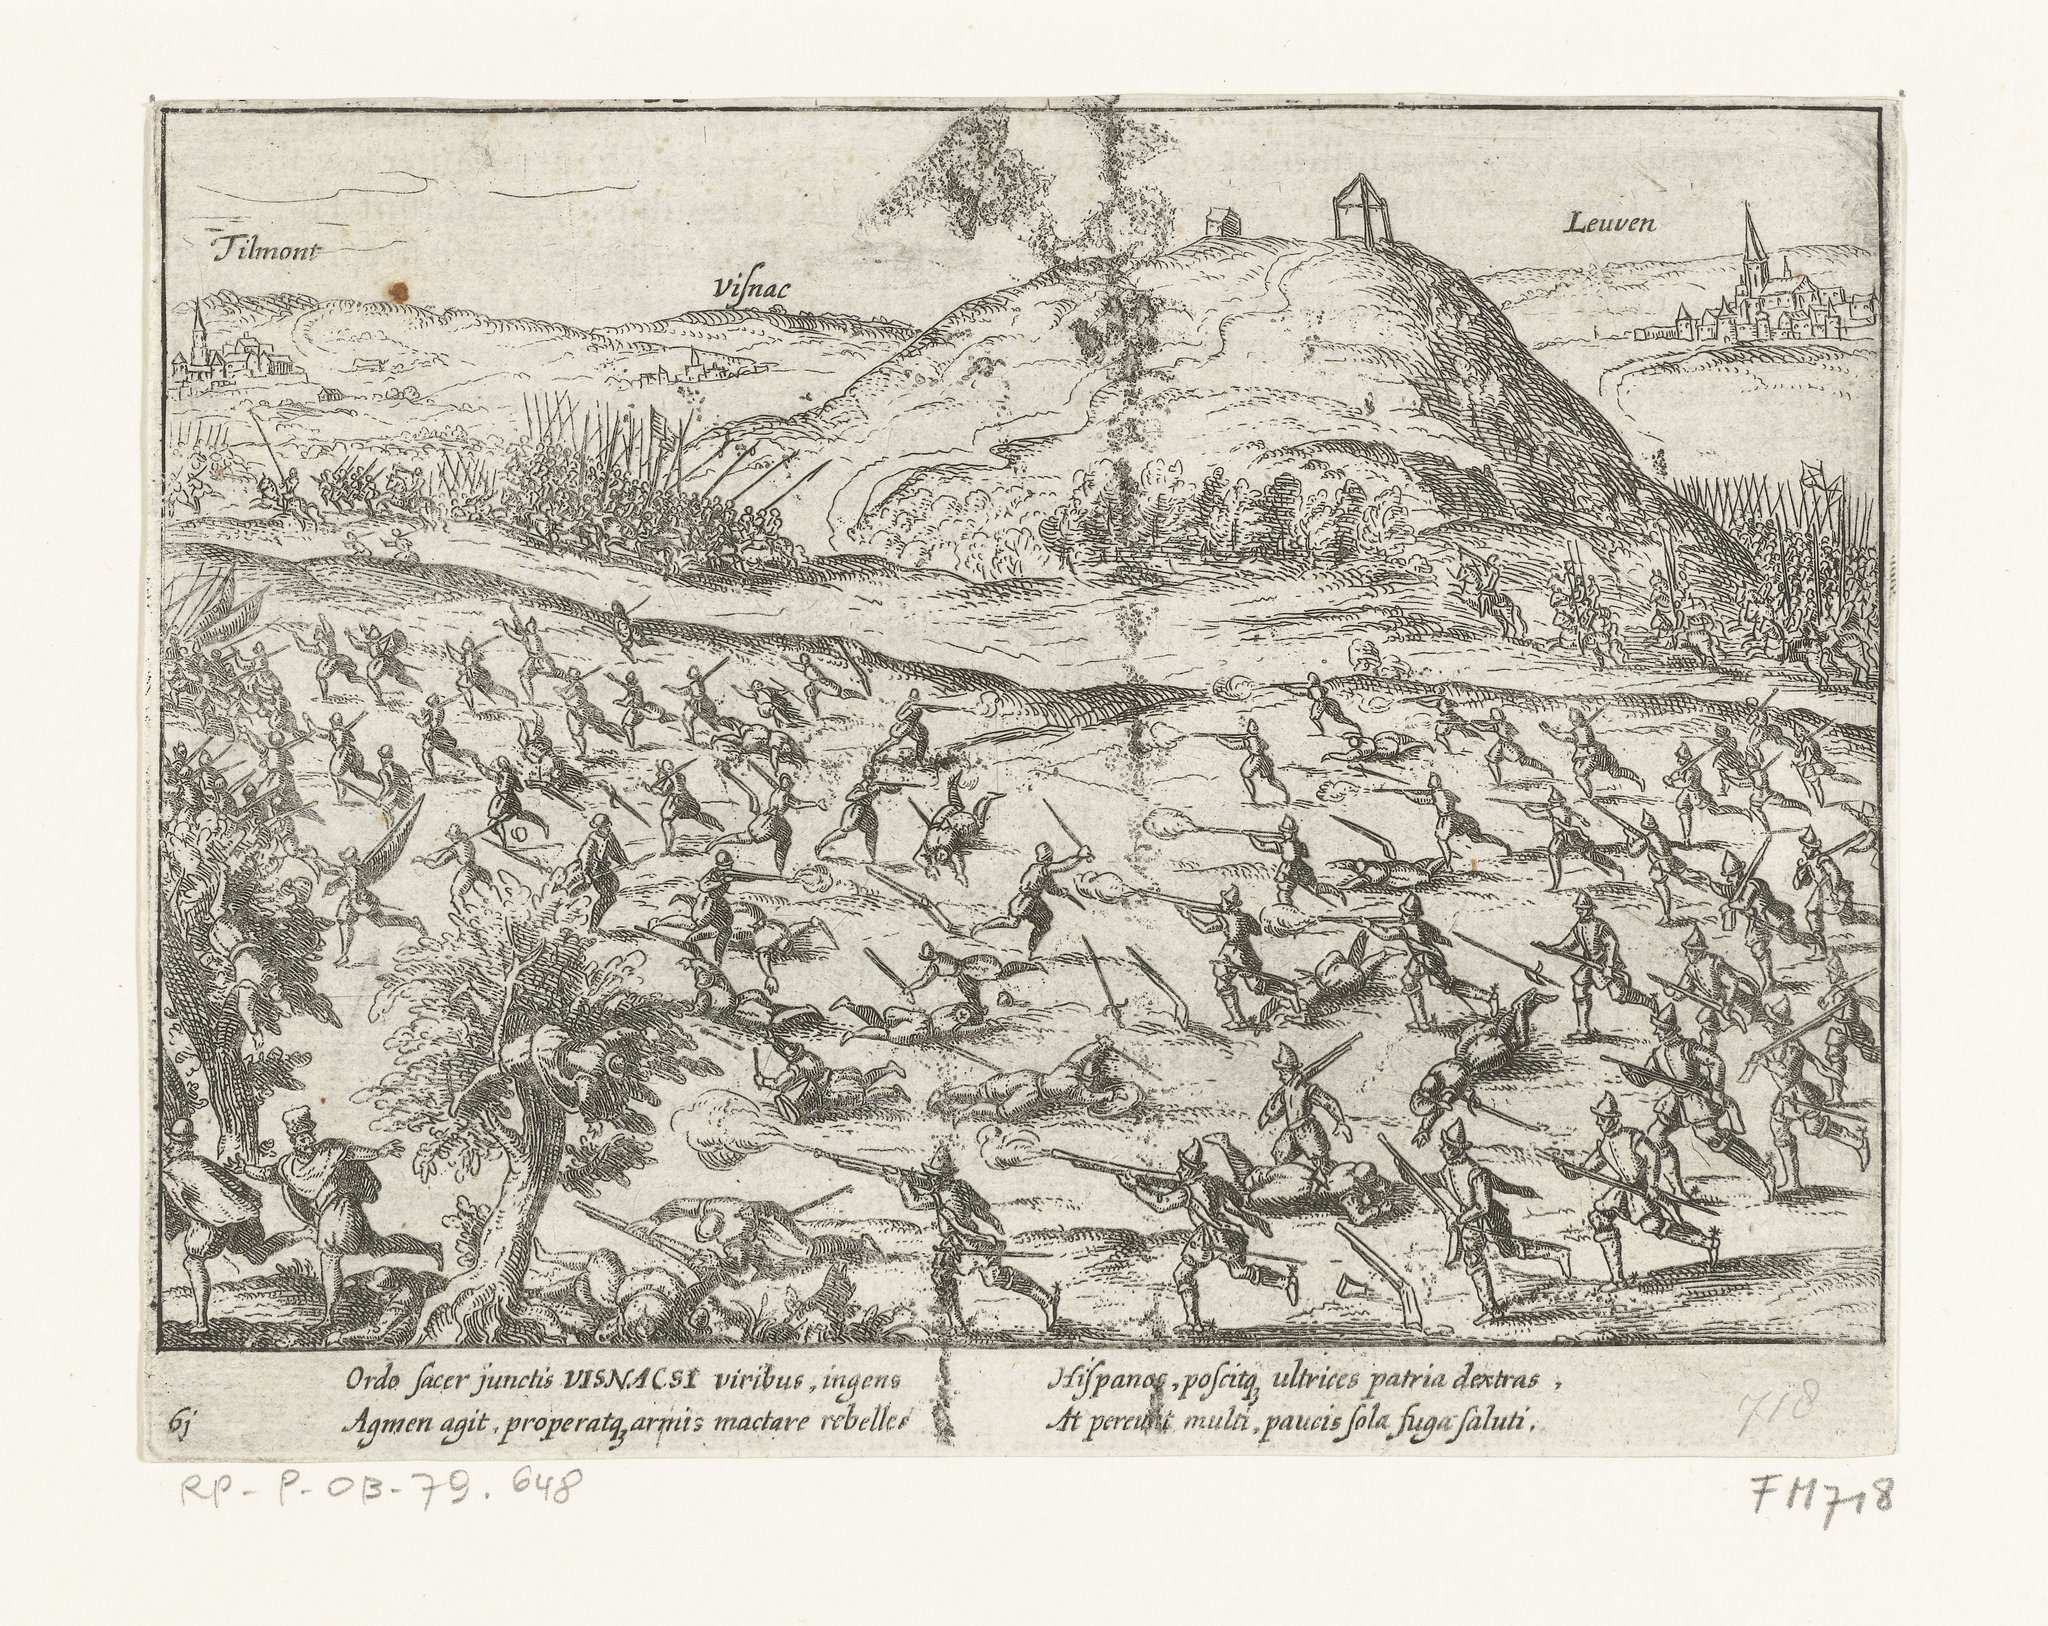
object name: history print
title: Slag bij Tienen, 1576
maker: Anonymous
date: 1613-1615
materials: paper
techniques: etching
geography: northern netherlands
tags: battle, louvain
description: Slag bij Tienen, september 1576. Gezicht op de veldslag tussen Spaanse leger onder Vargas en Mendoza en het Staatse leger. Linksonder vinden ook studenten en burgers uit Leuven hierbij de dood. Rechts in de verte de stad Tienen, links Roosbeek. Met onderschrift van 4 regels in het Latijn. Genummerd: 61. Bedrukt op achterzijde met tekst in het Latijn.